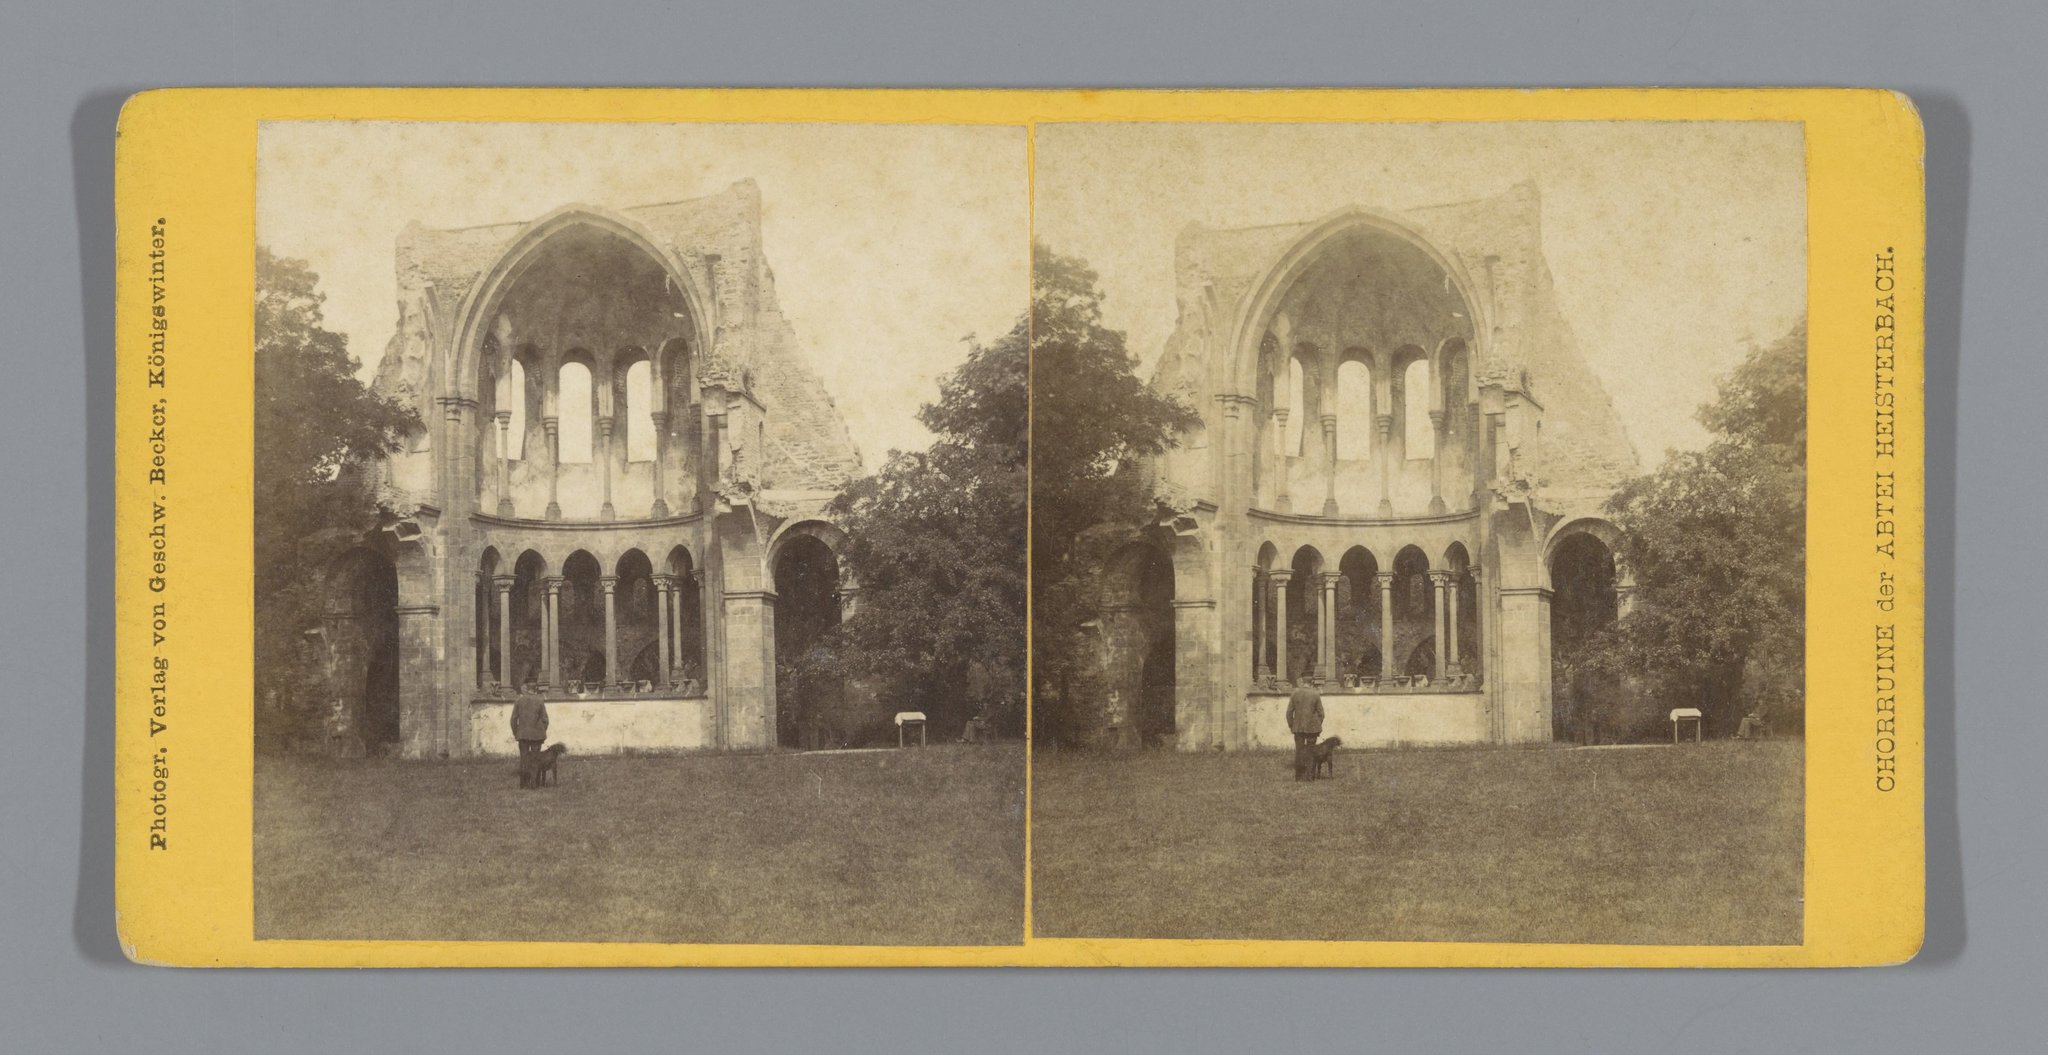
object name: stereograph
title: Chorruine der Abtei Heisterbach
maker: Anonymous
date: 1860-1880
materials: cardboard, photographic support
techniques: albumen print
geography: north rhine-westphalia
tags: ruin of church, monastery, etc.